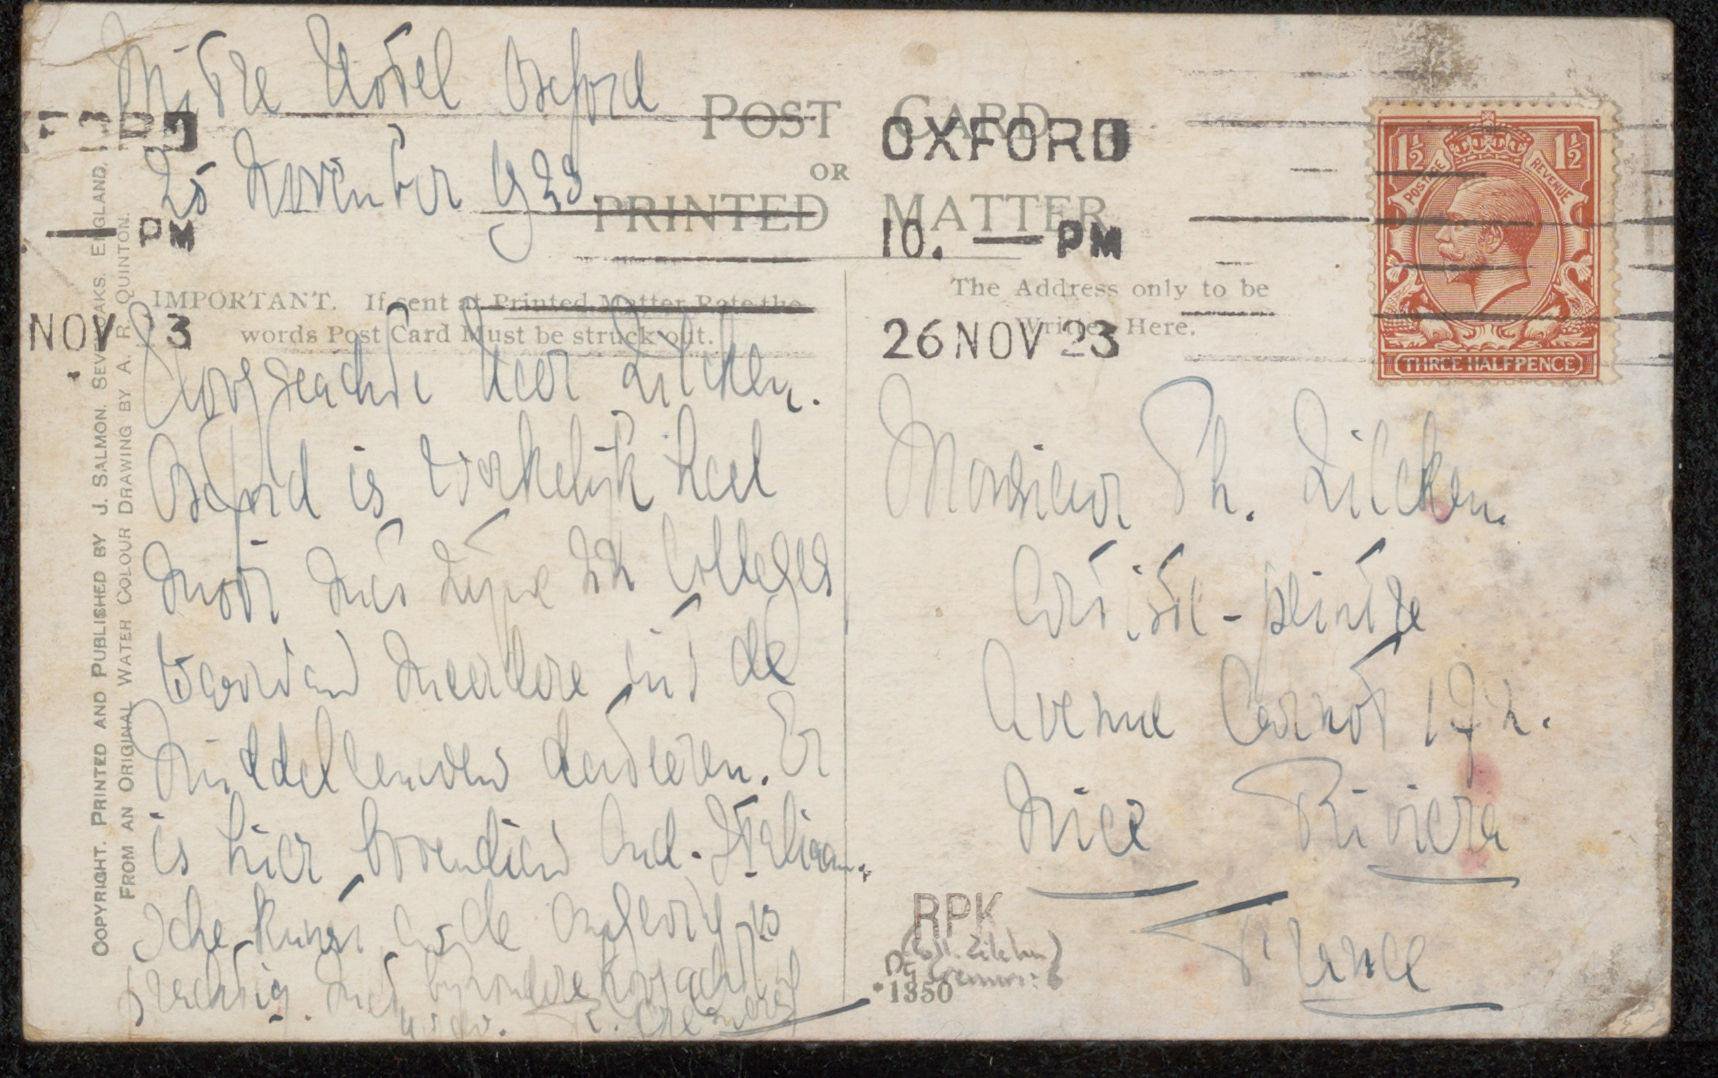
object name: ansichtkaart, prentbriefkaart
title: Prentbriefkaart aan Philip Zilcken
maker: r. cremers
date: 1923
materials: cardboard, ink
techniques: pen, printing, writing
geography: oxford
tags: the hague, painter, draughtsman, philip zilcken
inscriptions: collector's mark: ‘RPK’